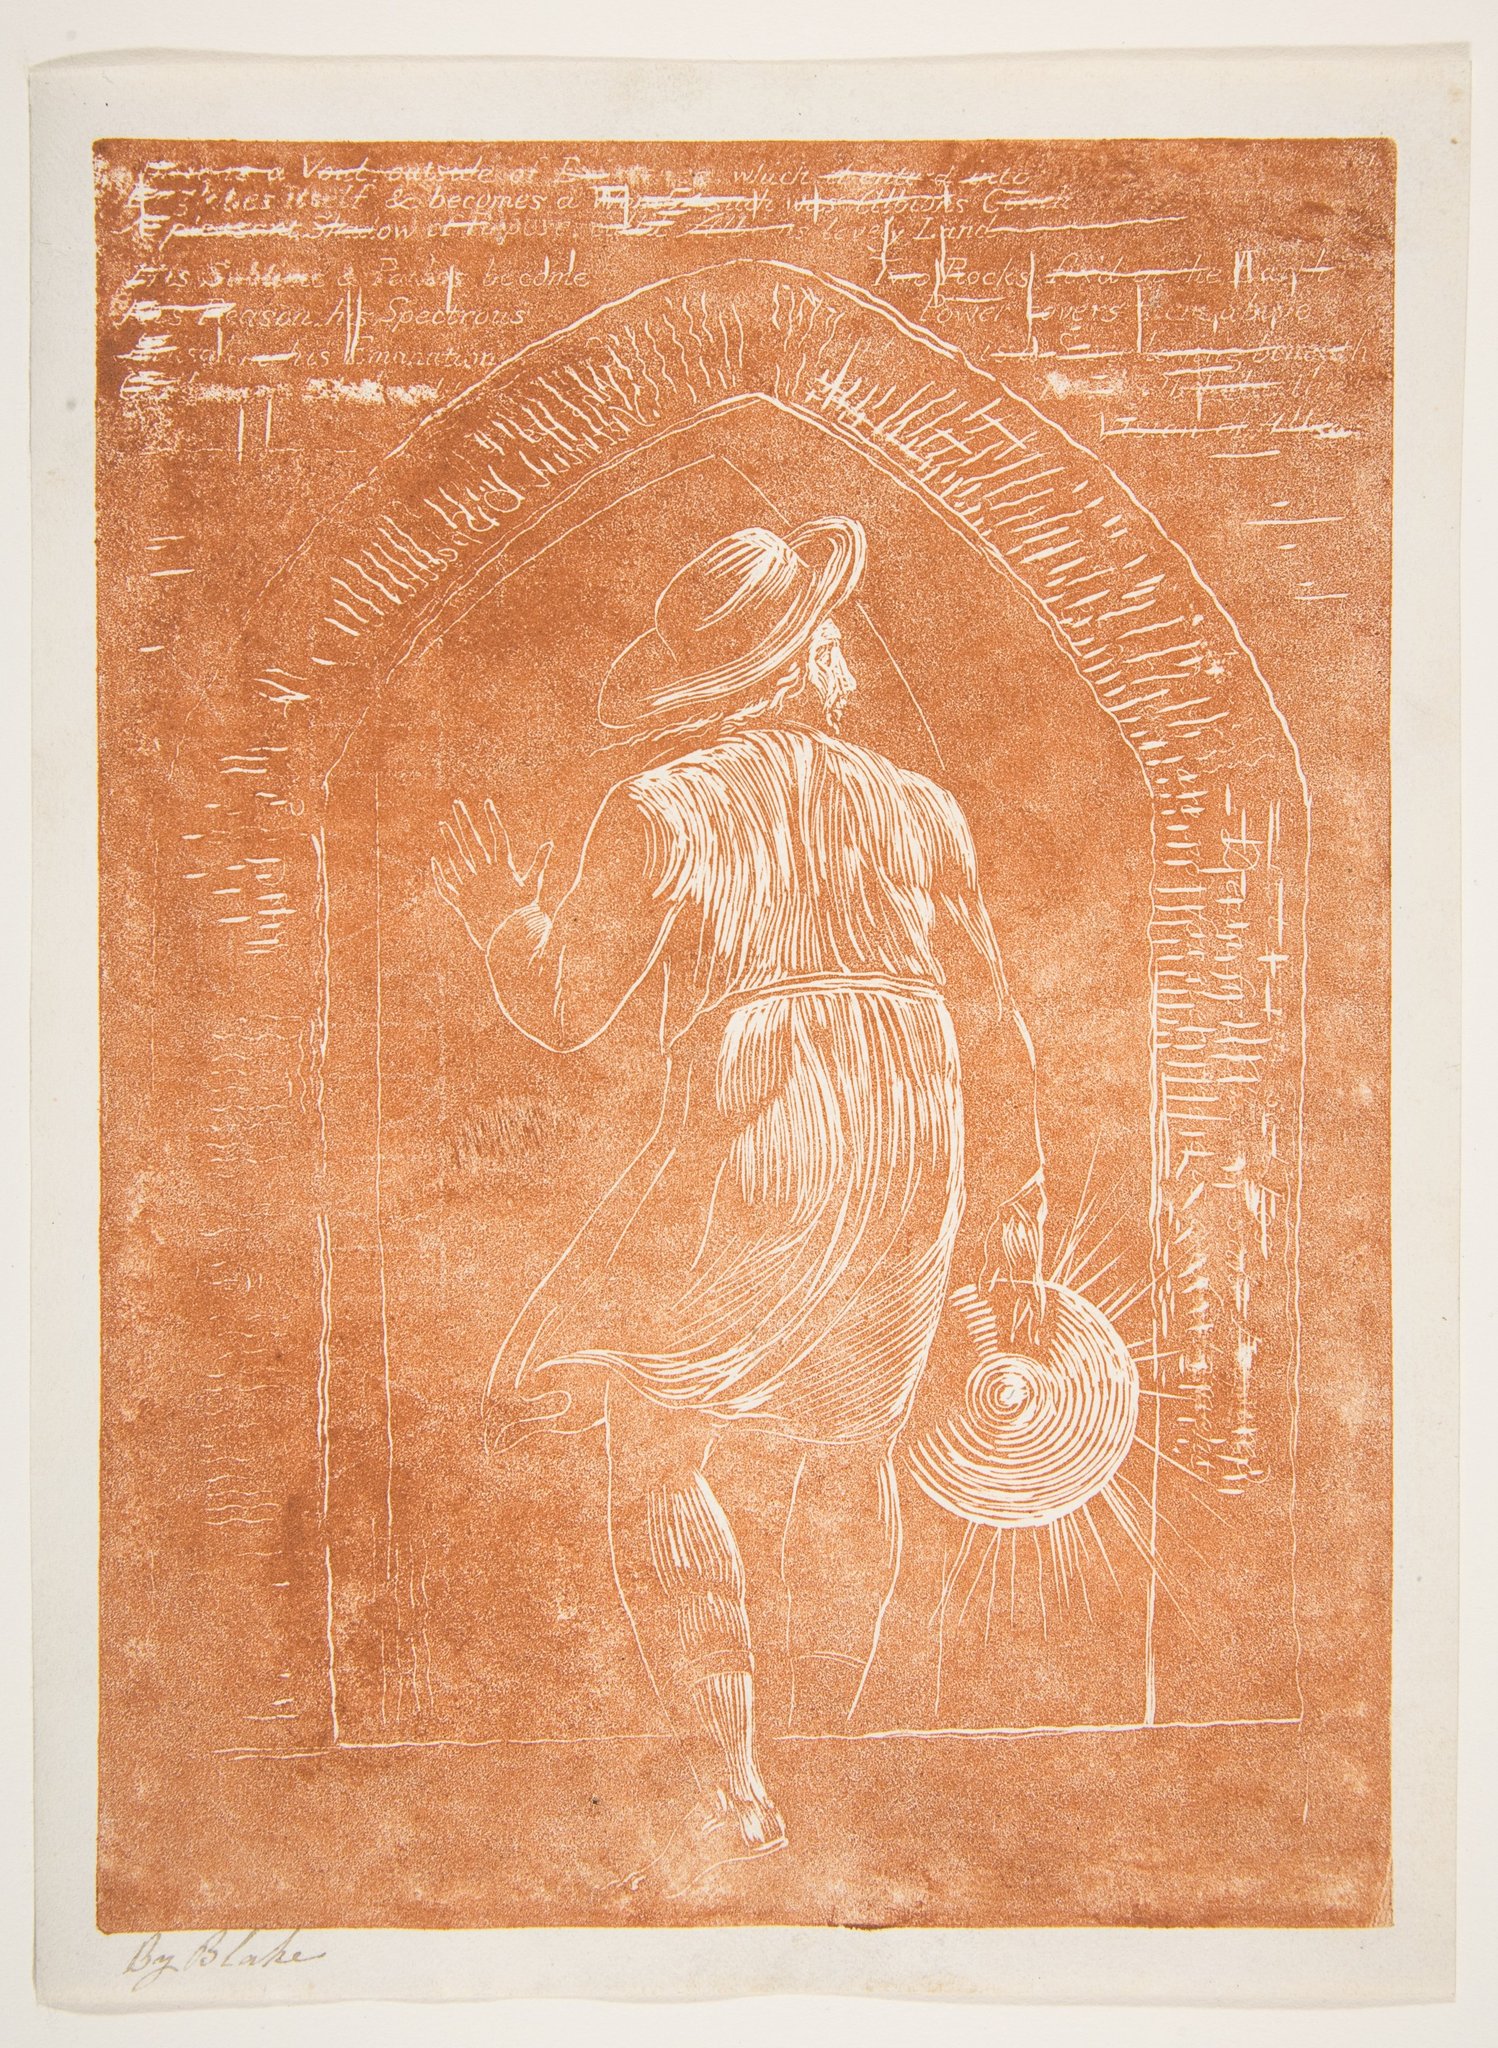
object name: print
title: Frontispiece to Jerusalem, the Emanation of the Great Albion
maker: william blake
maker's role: artist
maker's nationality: british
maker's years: 1757-1827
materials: ink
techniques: engraving, printing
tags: men